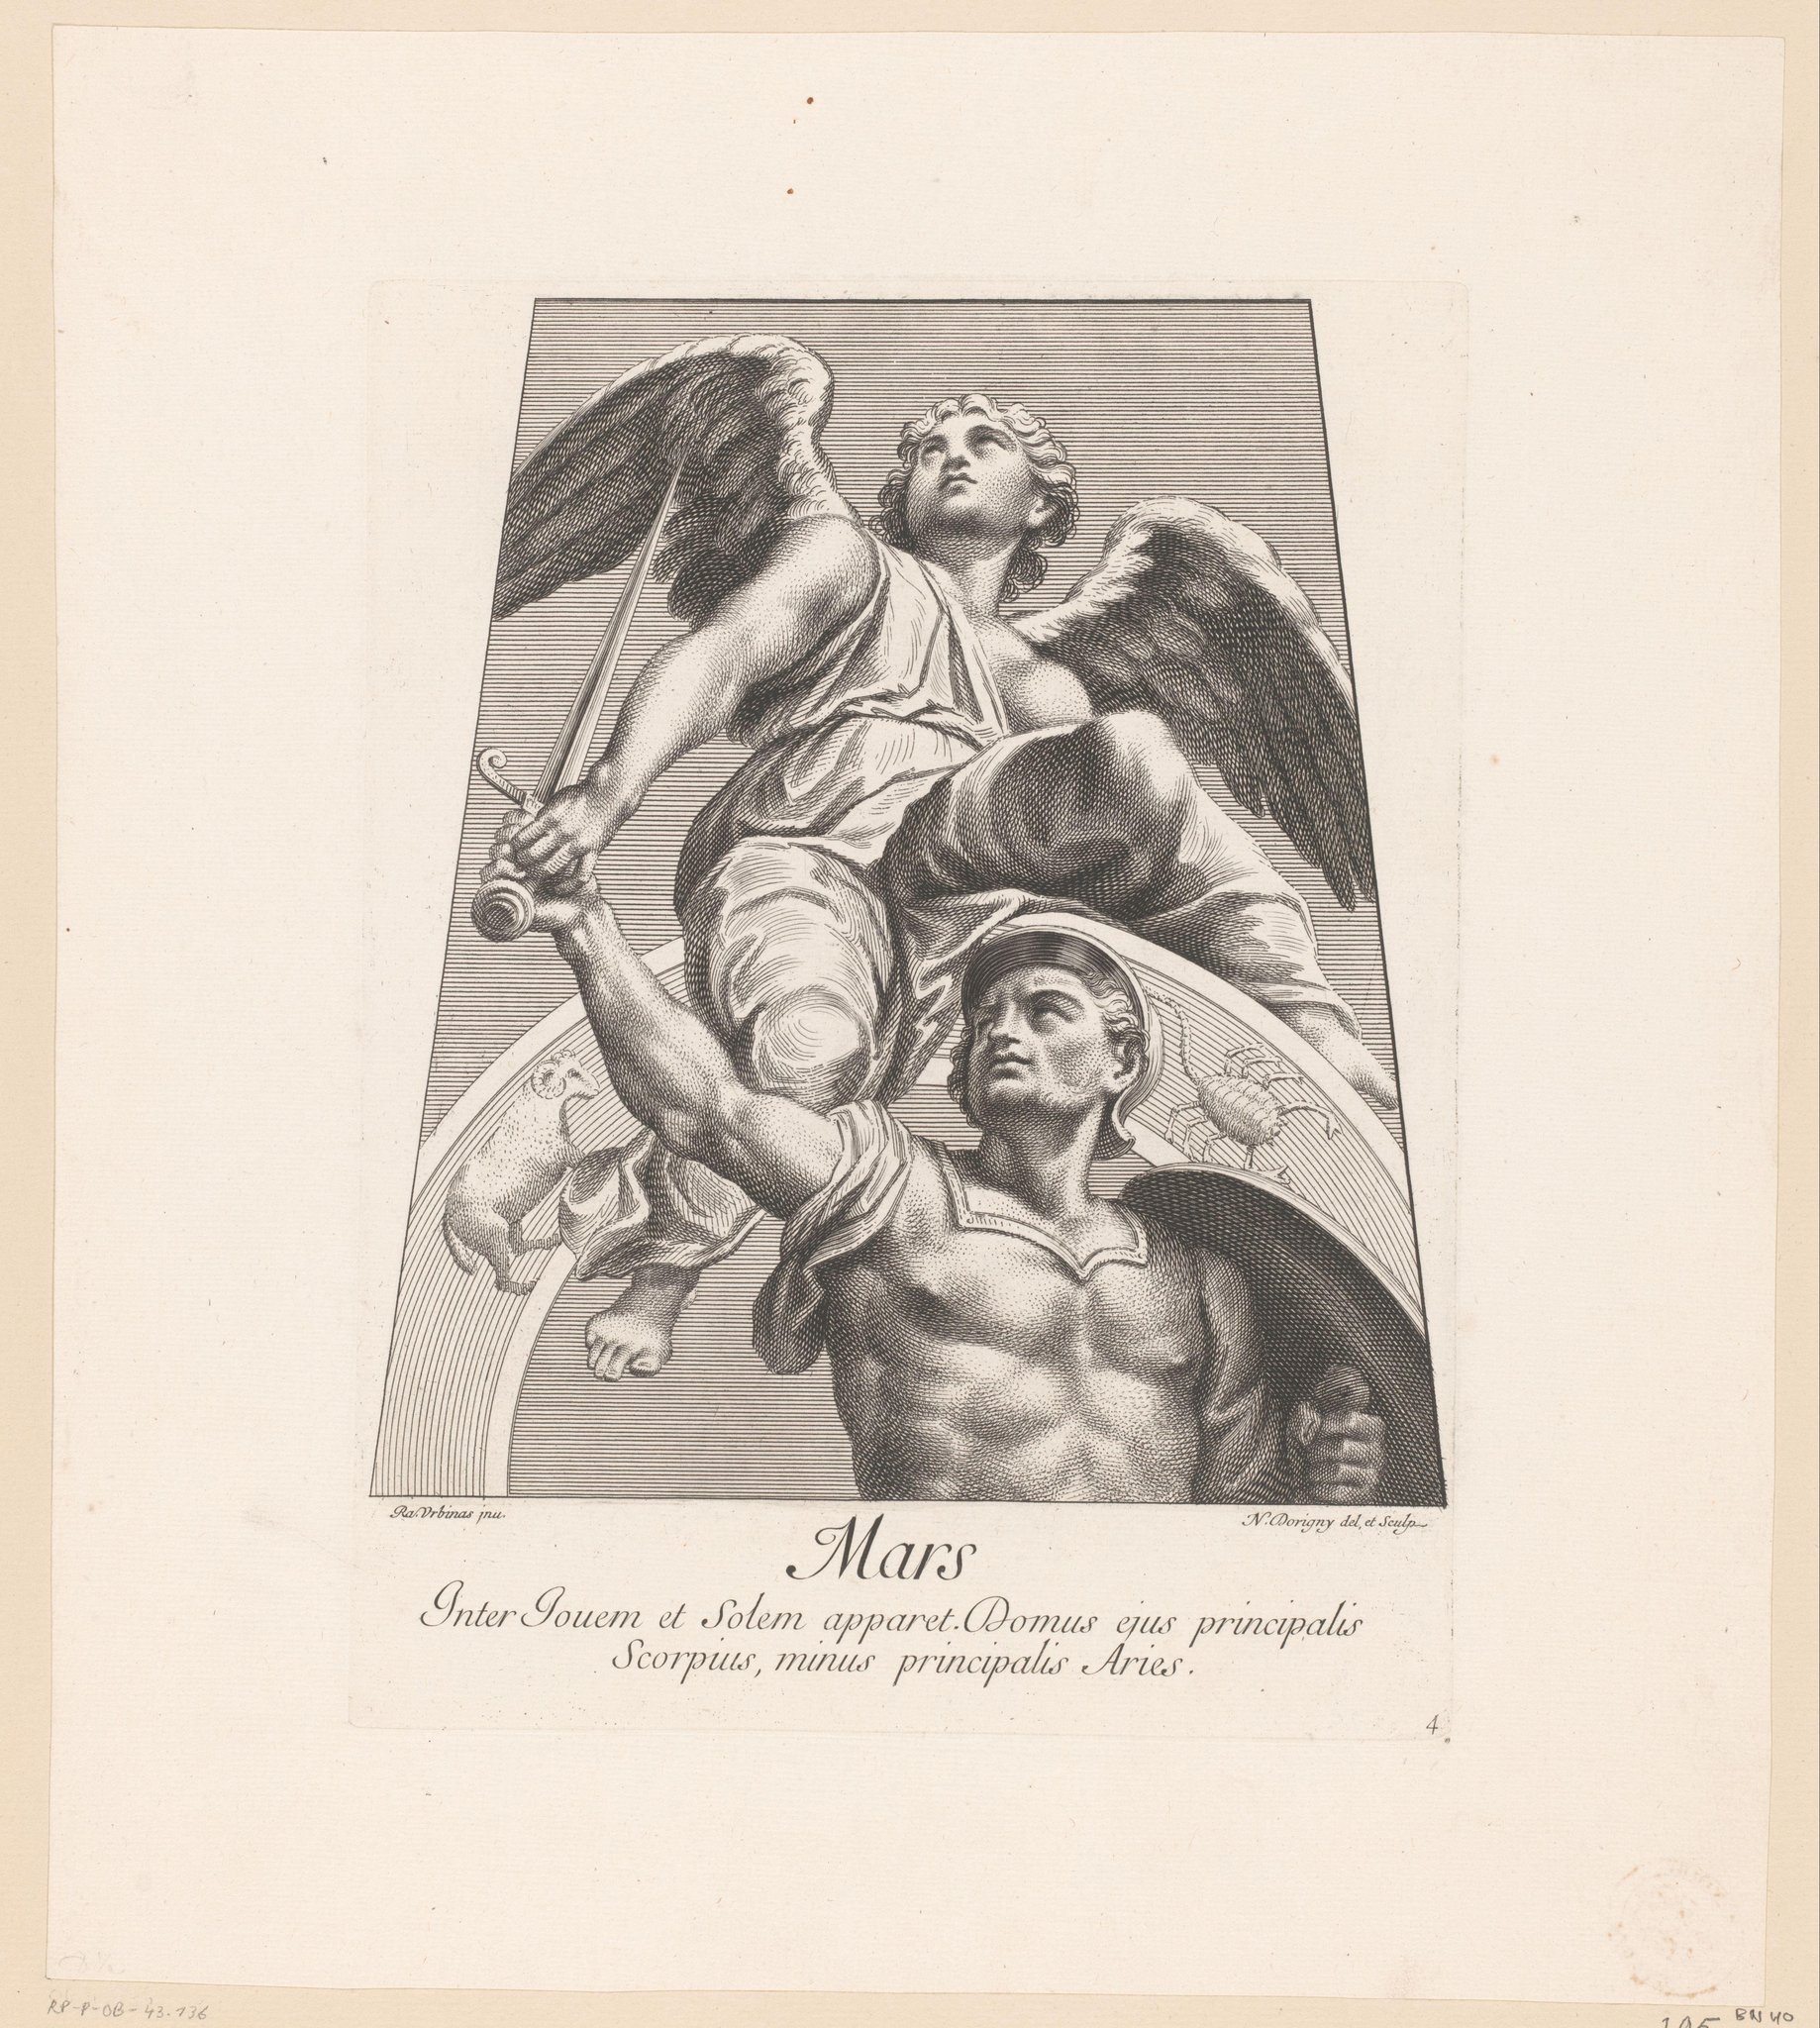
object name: print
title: Serie naar schilderingen van Rafaël in de Chigi-kapel in Rome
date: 1695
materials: paper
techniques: engraving, etching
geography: rome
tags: (story of) mars (ares), mars (planet), angels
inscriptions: collector's mark: Lugt 240